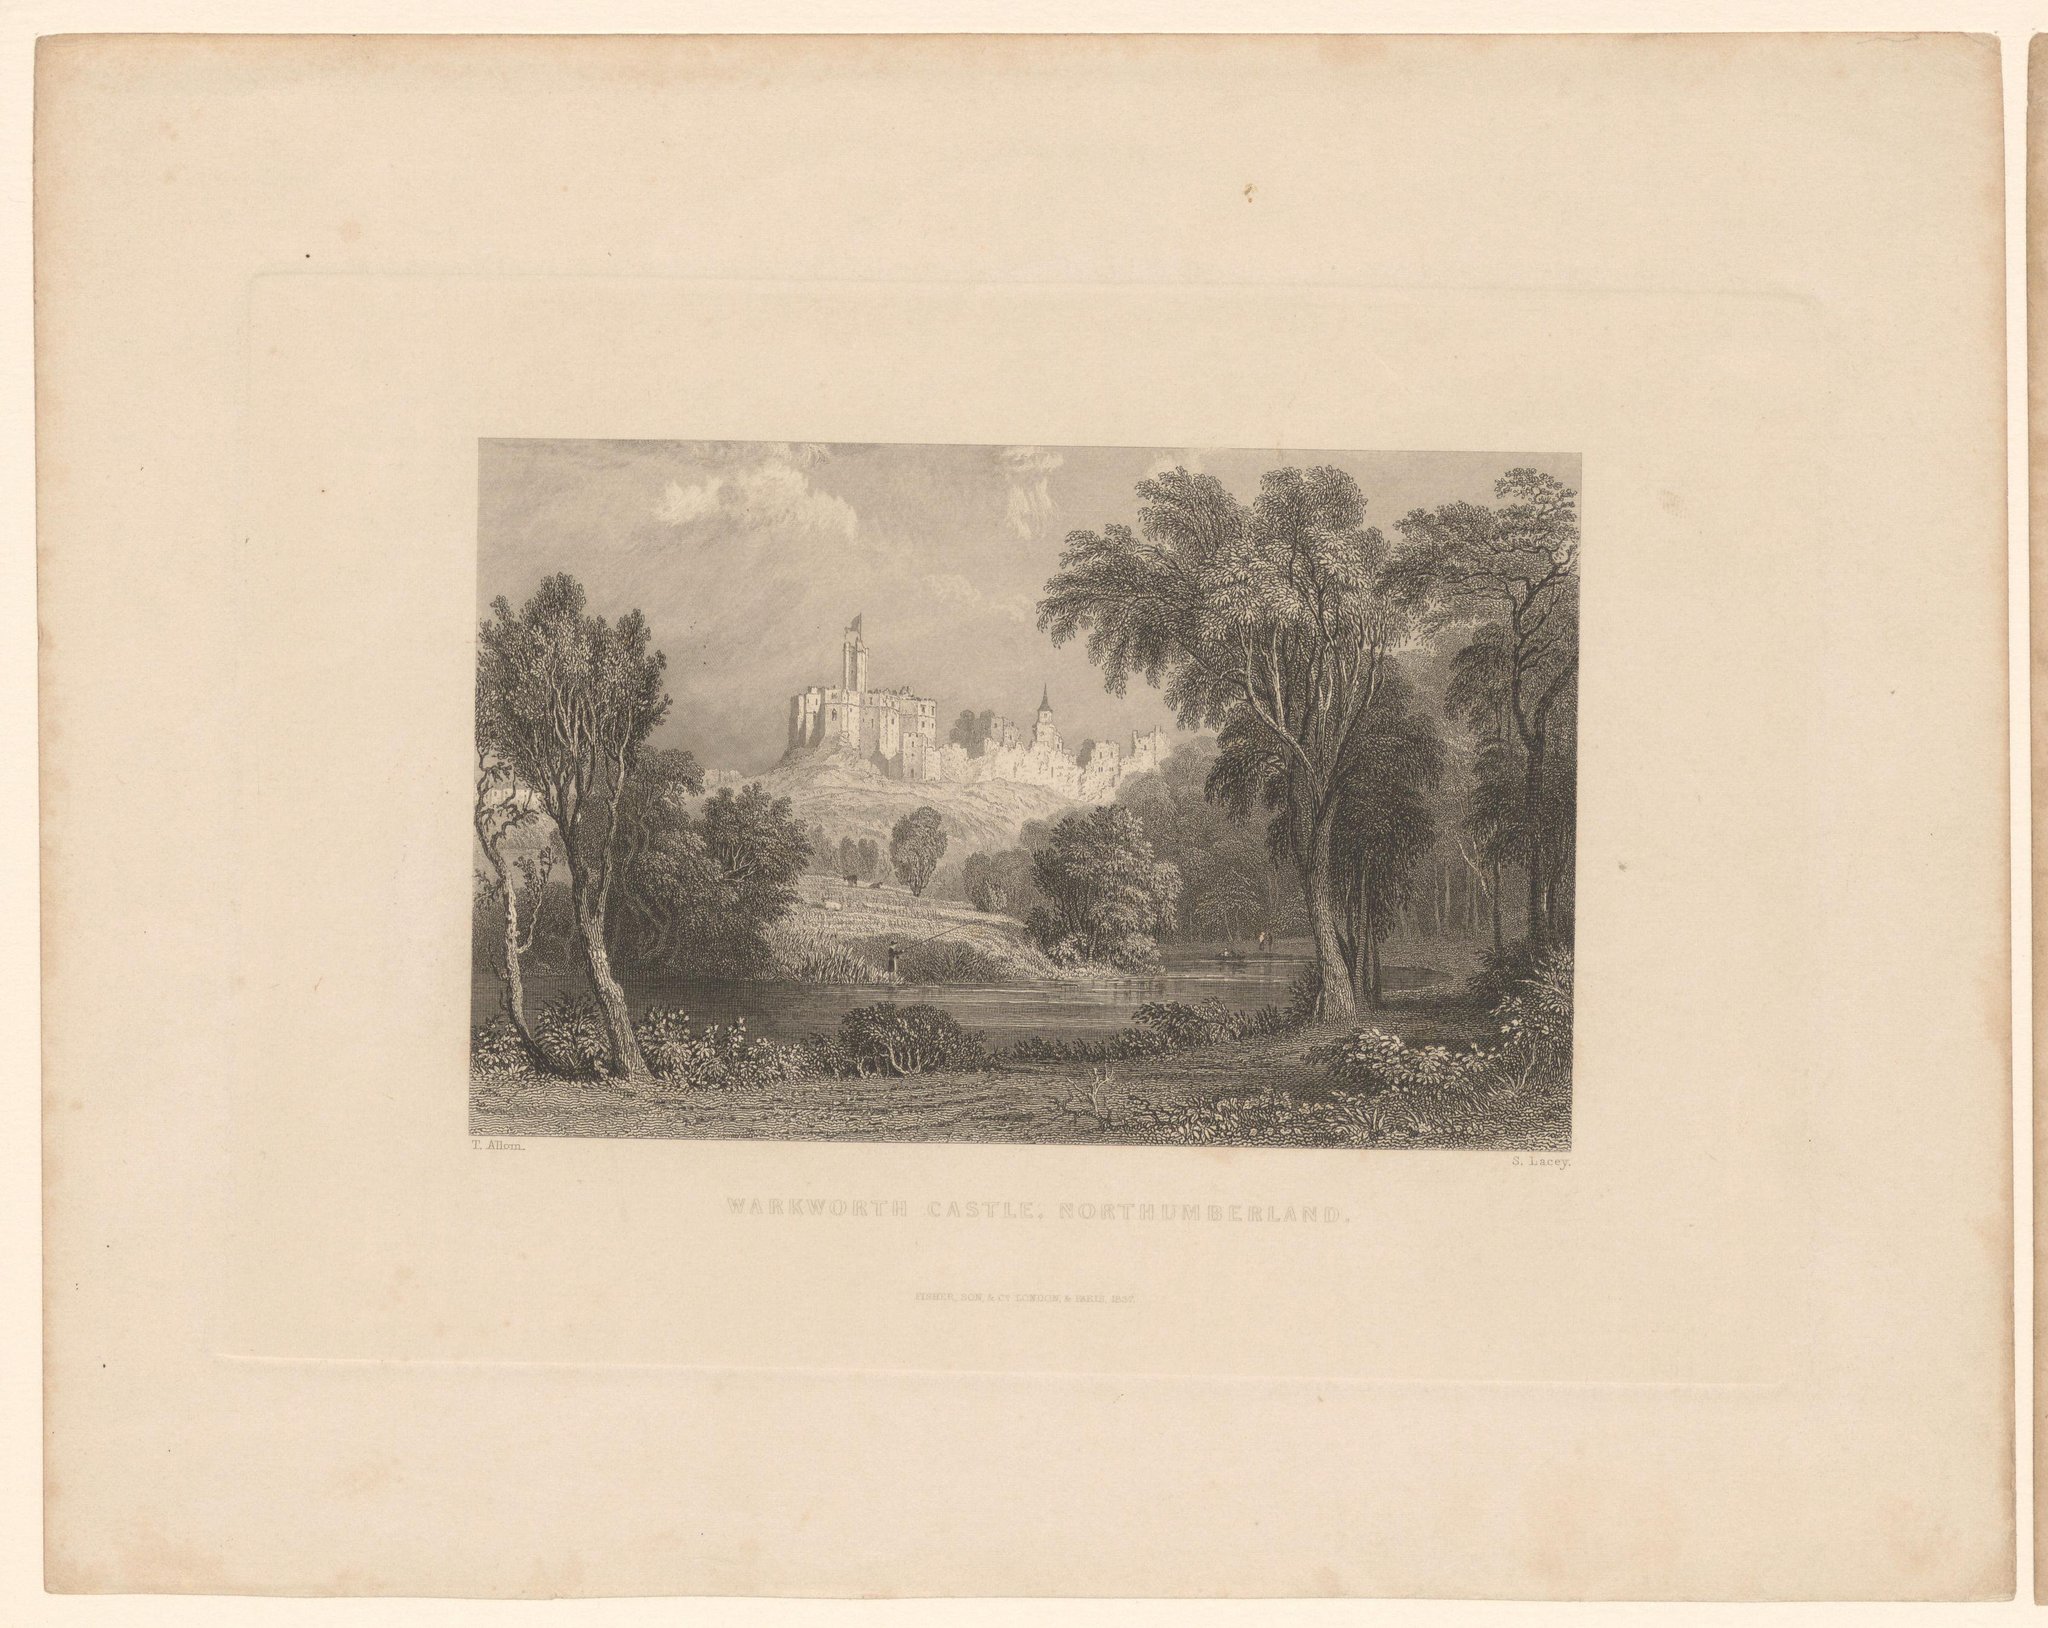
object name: print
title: Gezicht op Warkworth Castle over de Coquet gezien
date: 1837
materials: paper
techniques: engraving, etching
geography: paris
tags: fortress, river (+ landscape with figures, staffage)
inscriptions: collector's mark: Lugt 2228